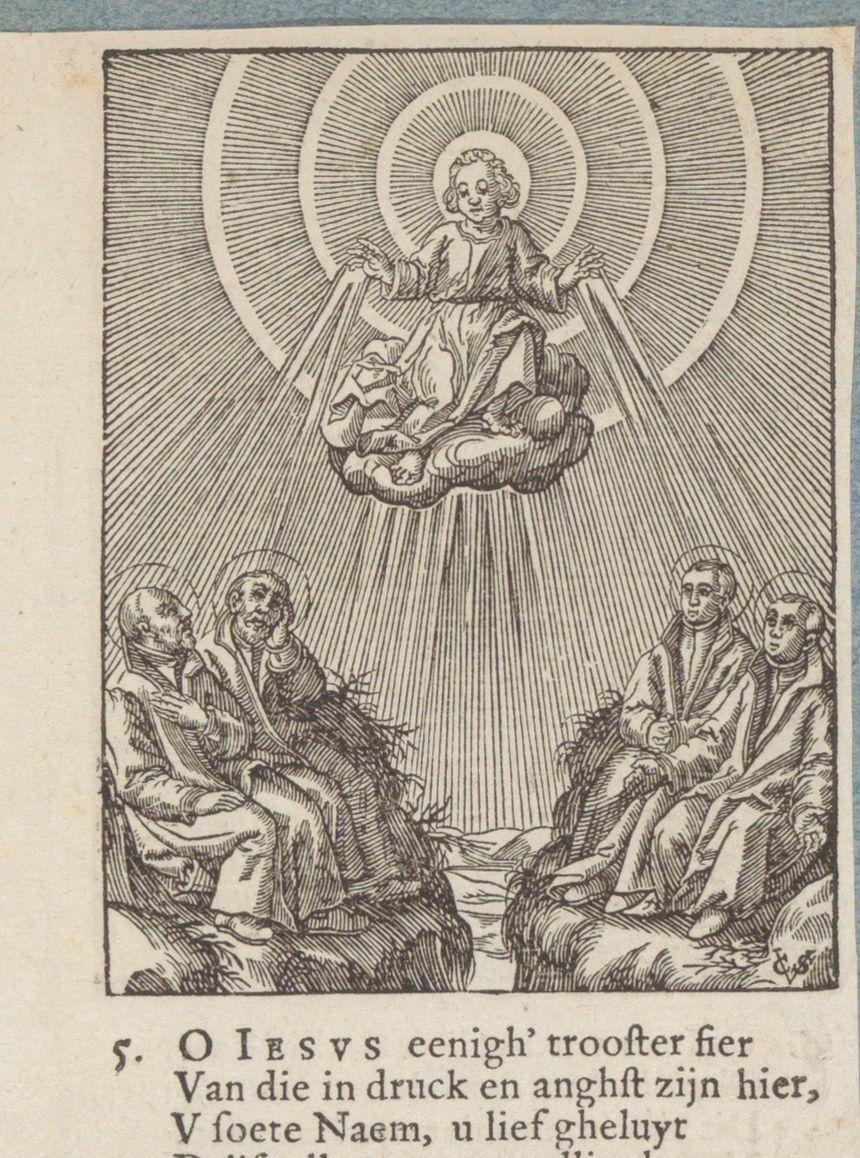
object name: book illustration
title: Christuskind met Jezuïeten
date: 1629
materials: paper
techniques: letterpress printing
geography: amsterdam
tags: rome, clergyman, missionary, the jesuit friar aloysius gonzaga; possible attributes: crucifix, discipline, lily, skull, christ-child (with attributes), the founder of the jesuit order, ignatius of loyola; possible attributes: book (with 'ad majorem dei gloriam'), demon, dragon under feet, flames, flaming heart, globe, ihs monogram, skull (with crown), tears in eyes, torch, the jesuit missionary francis xavier; possible attributes: cross, crucifix, flaming heart, indian, lily, torch, male saints (with name)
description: Vanaf een wolk zegent het Christuskind met stralen de vier Jezuïeten Ignatius van Loyola, Francis Xavier, Aloysius Gonzaga en Stanislaus Kostka. Onder de voorstelling genummerd 5 en met vier regels tekst. De prent maakt deel uit van een album.